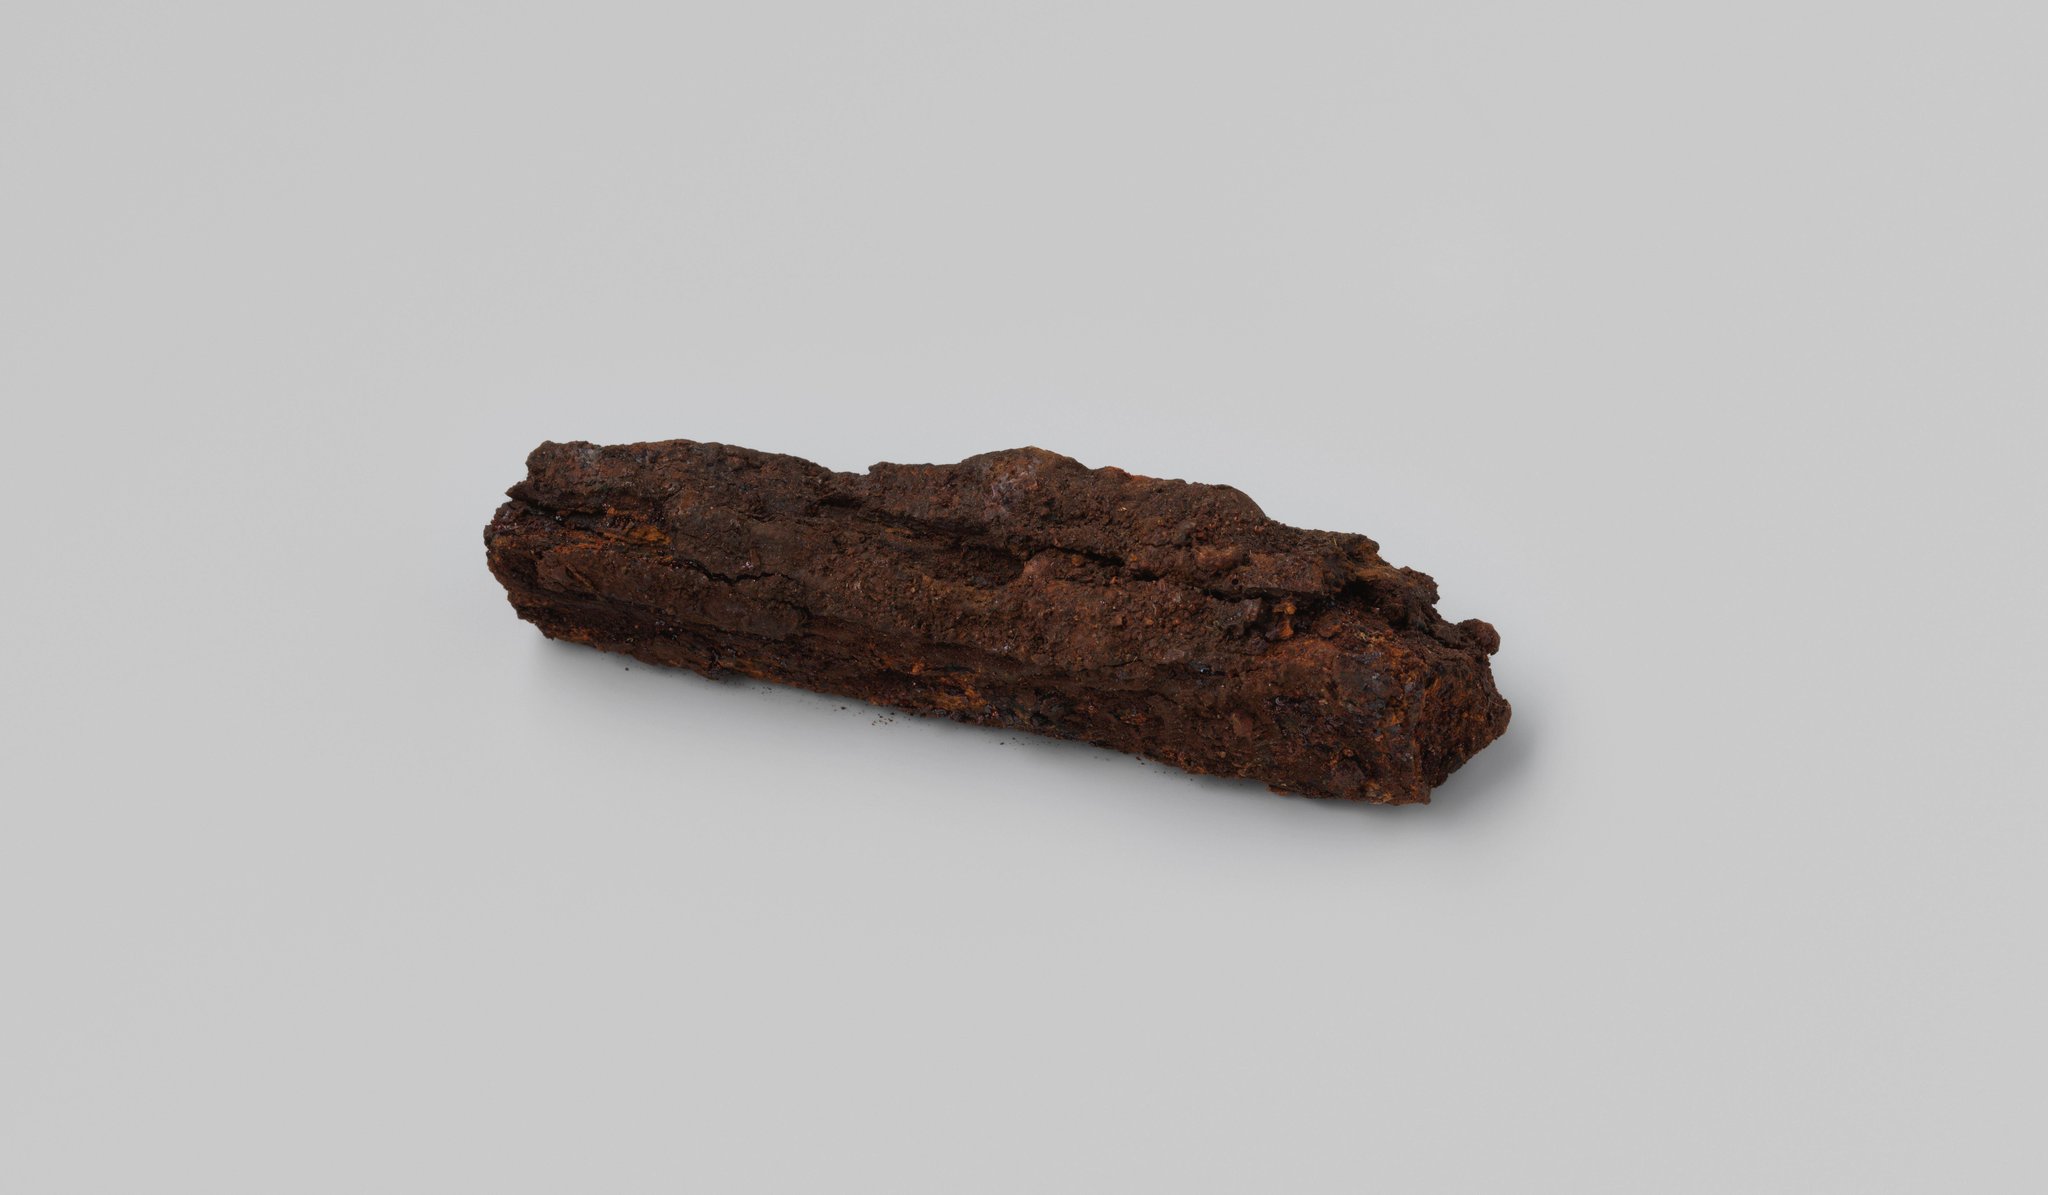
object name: fragment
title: Fragment of onderdeel uit het wrak van de Oost-Indiëvaarder Hollandia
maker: Anonymous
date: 1743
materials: iron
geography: netherlands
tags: verenigde oostindische compagnie, hollandia (schip), annet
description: Varied parts or fragments, bar(-shaped) fragments (bars, rods etc.); fragm, heavily eroded, broken, sim. 80H1763.